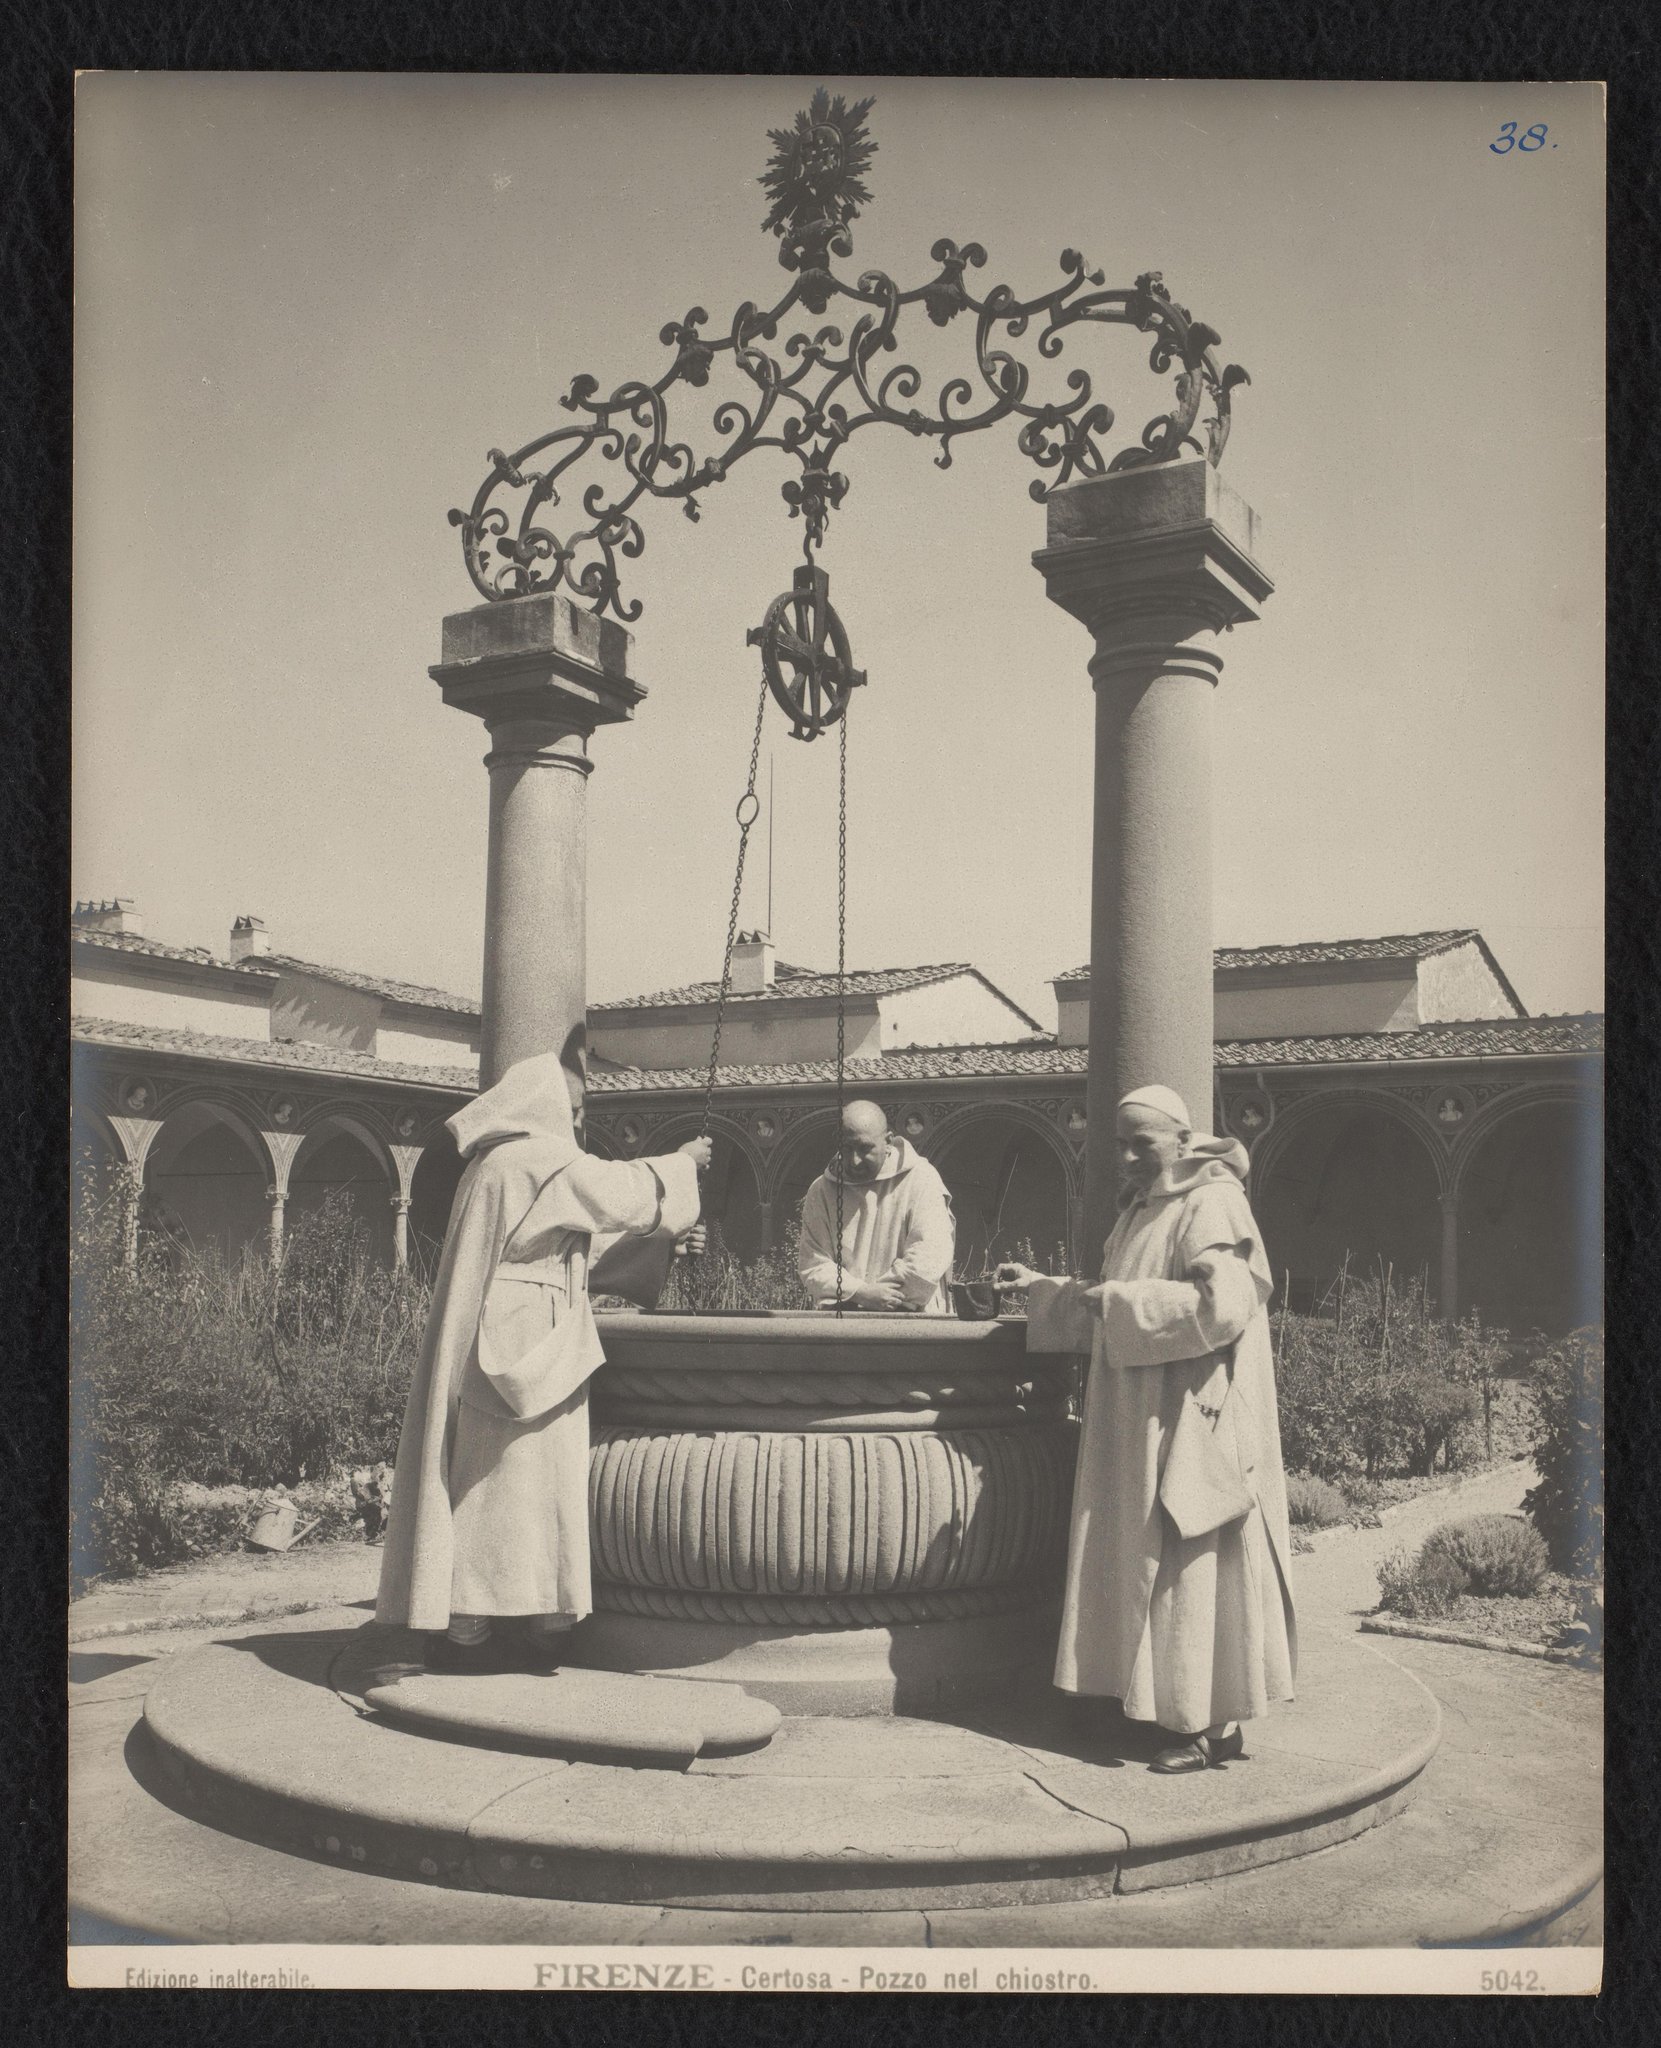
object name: photograph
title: Certosa - Pozzo nel chiostro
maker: Anonymous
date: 1901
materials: paper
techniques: gelatin silver print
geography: berlin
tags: well, cloisters ~ monastery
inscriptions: inscription: ‘Edizione inalterabile.’, number: ‘38.’, number: ‘5042.’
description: Deze foto maakt deel uit van een omslag.